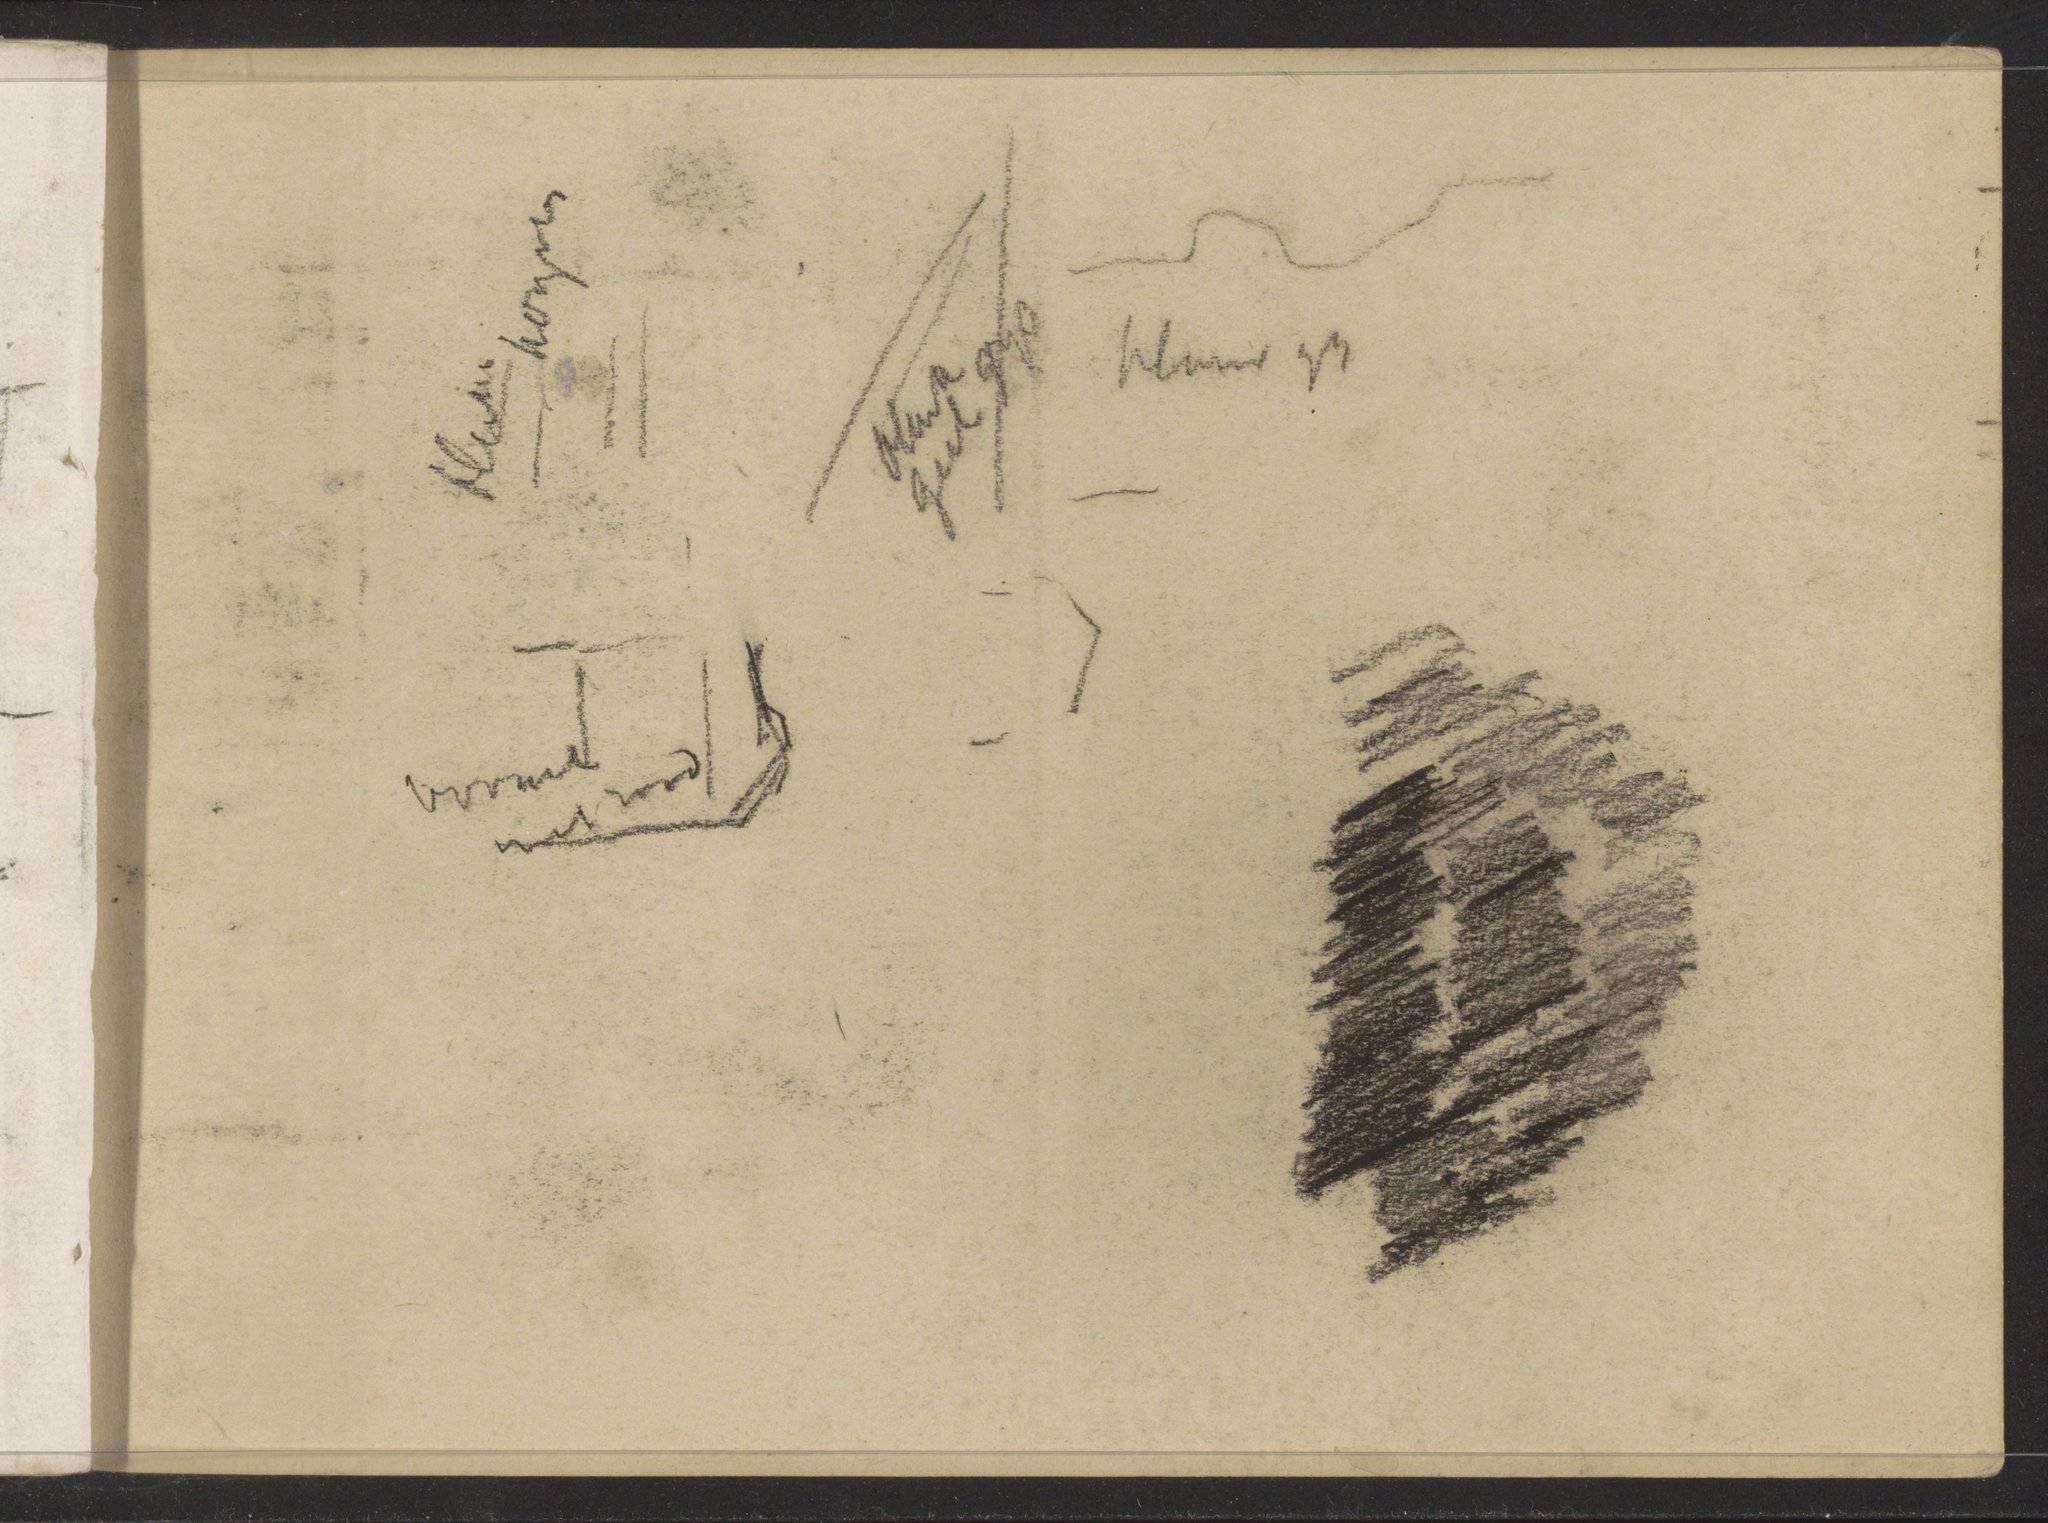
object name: sketchbook leaf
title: Studieblad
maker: willem witsen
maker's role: draughtsman, painter, print maker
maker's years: 1860-1923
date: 1897-1899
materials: chalk, paper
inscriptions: kleurnotitie, handgeschreven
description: Schutblad B, achterste schutblad, uit een schetsboek met 17 bladen.